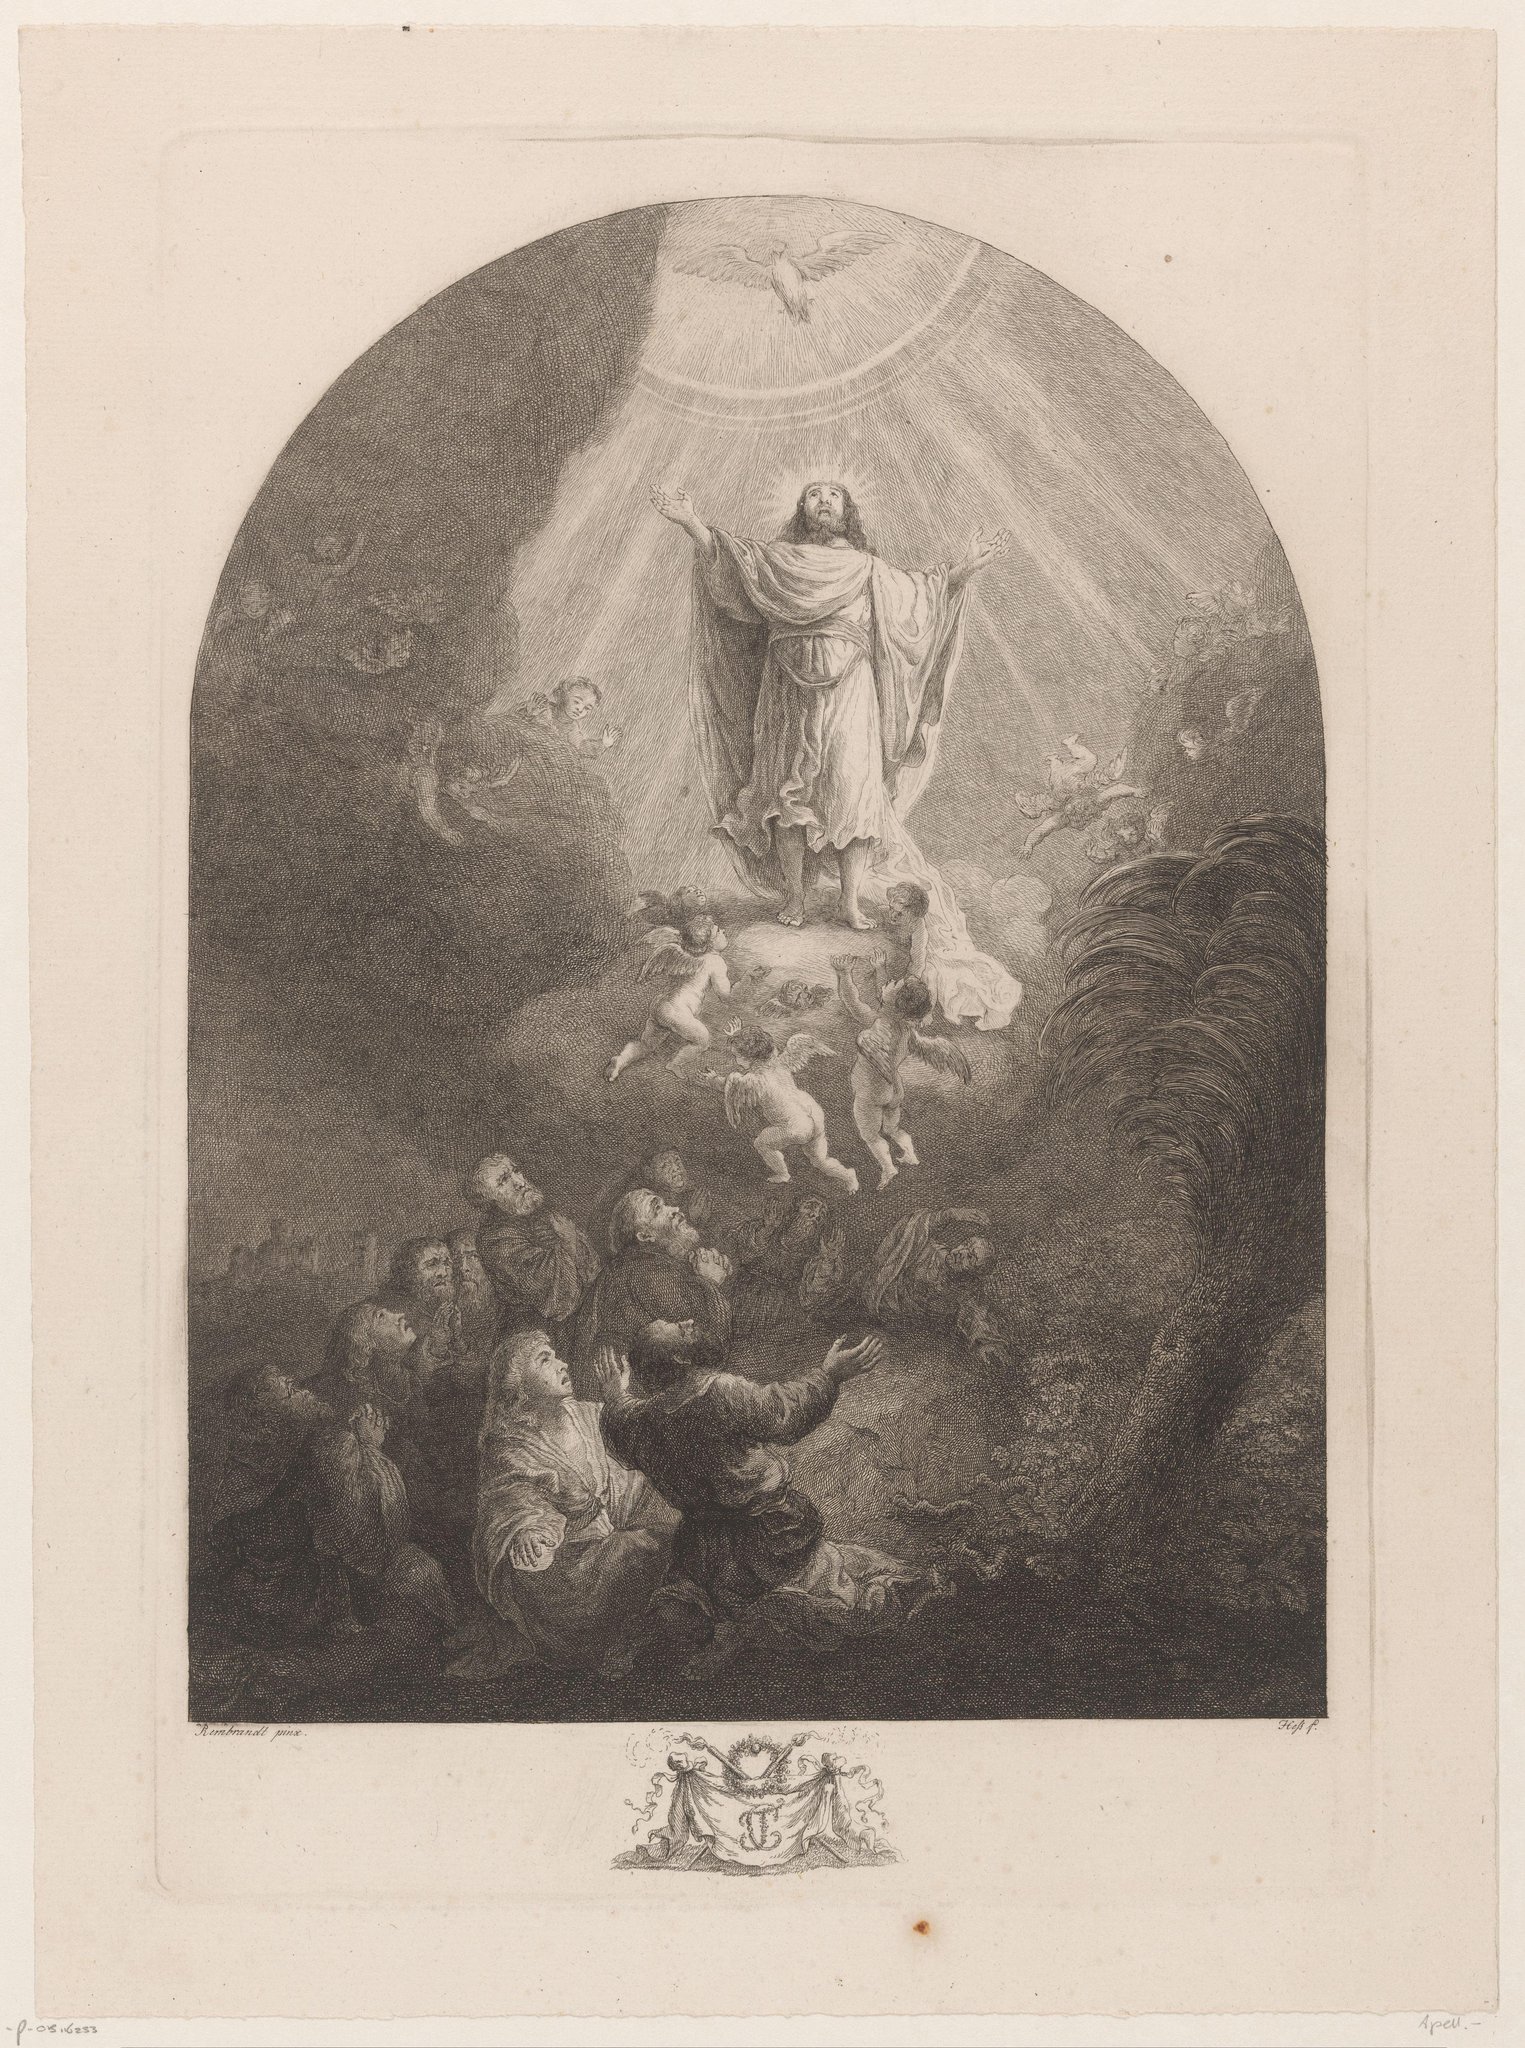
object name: print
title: Hemelvaart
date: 1765-1828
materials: paper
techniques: etching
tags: christ taken up by a cloud ~ ascension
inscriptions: collector's mark: Lugt 240